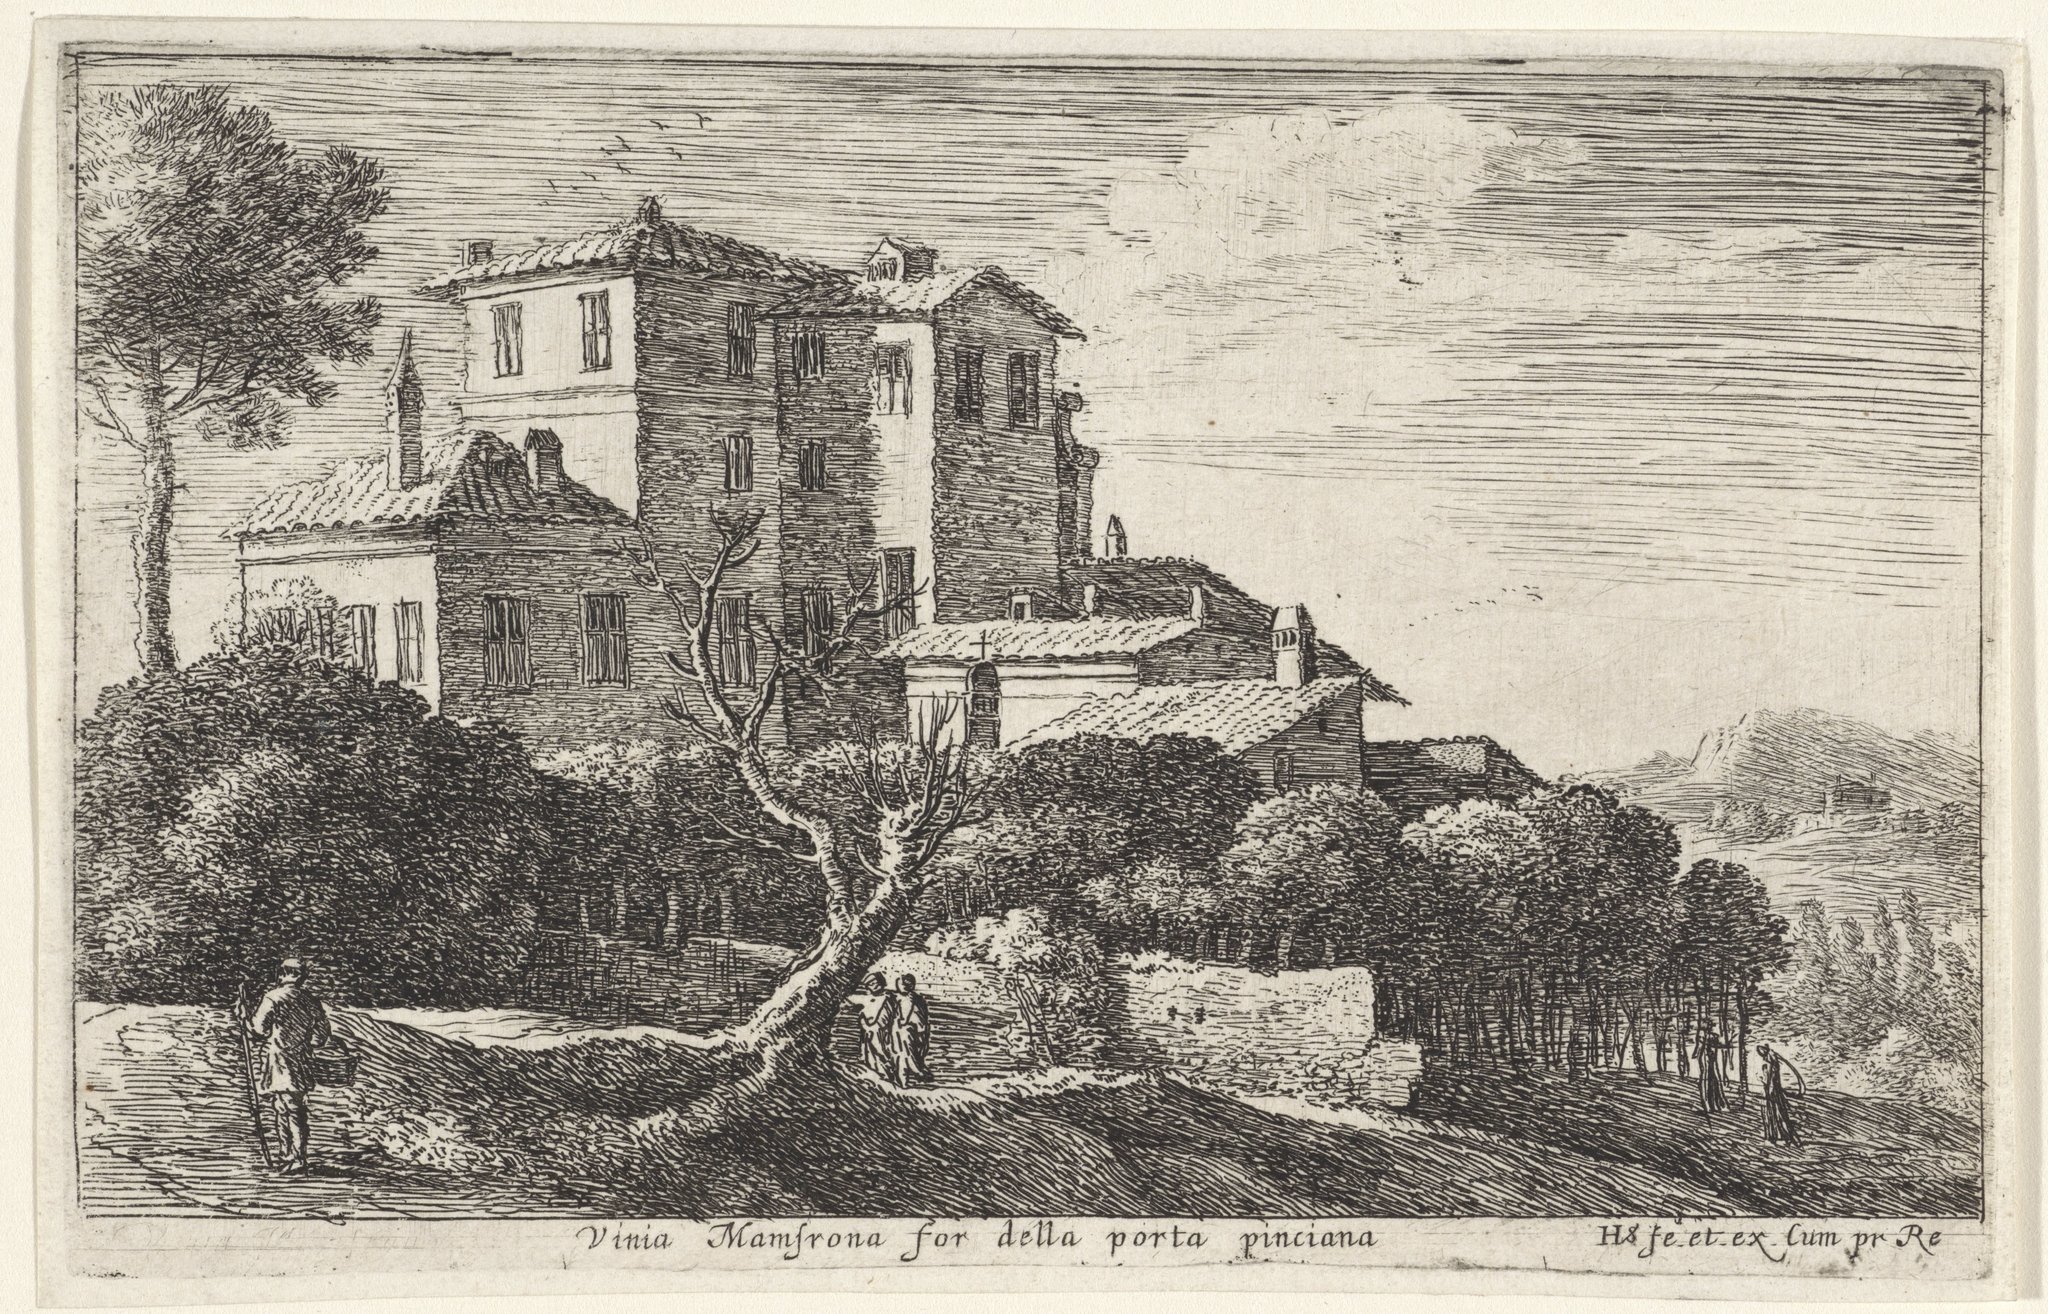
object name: print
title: Gezicht op de wijngaard van Villa Mamsrona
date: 1652-1653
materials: paper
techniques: etching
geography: paris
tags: vineyard, landscapes, villa, rome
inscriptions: collector's mark: Lugt 240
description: Villa Mamsrona ligt door bomen omgeven op een heuvel in de buurt van de Porta Pinciana. Op het pad rond het gebouw zijn enkele figuren te zien.